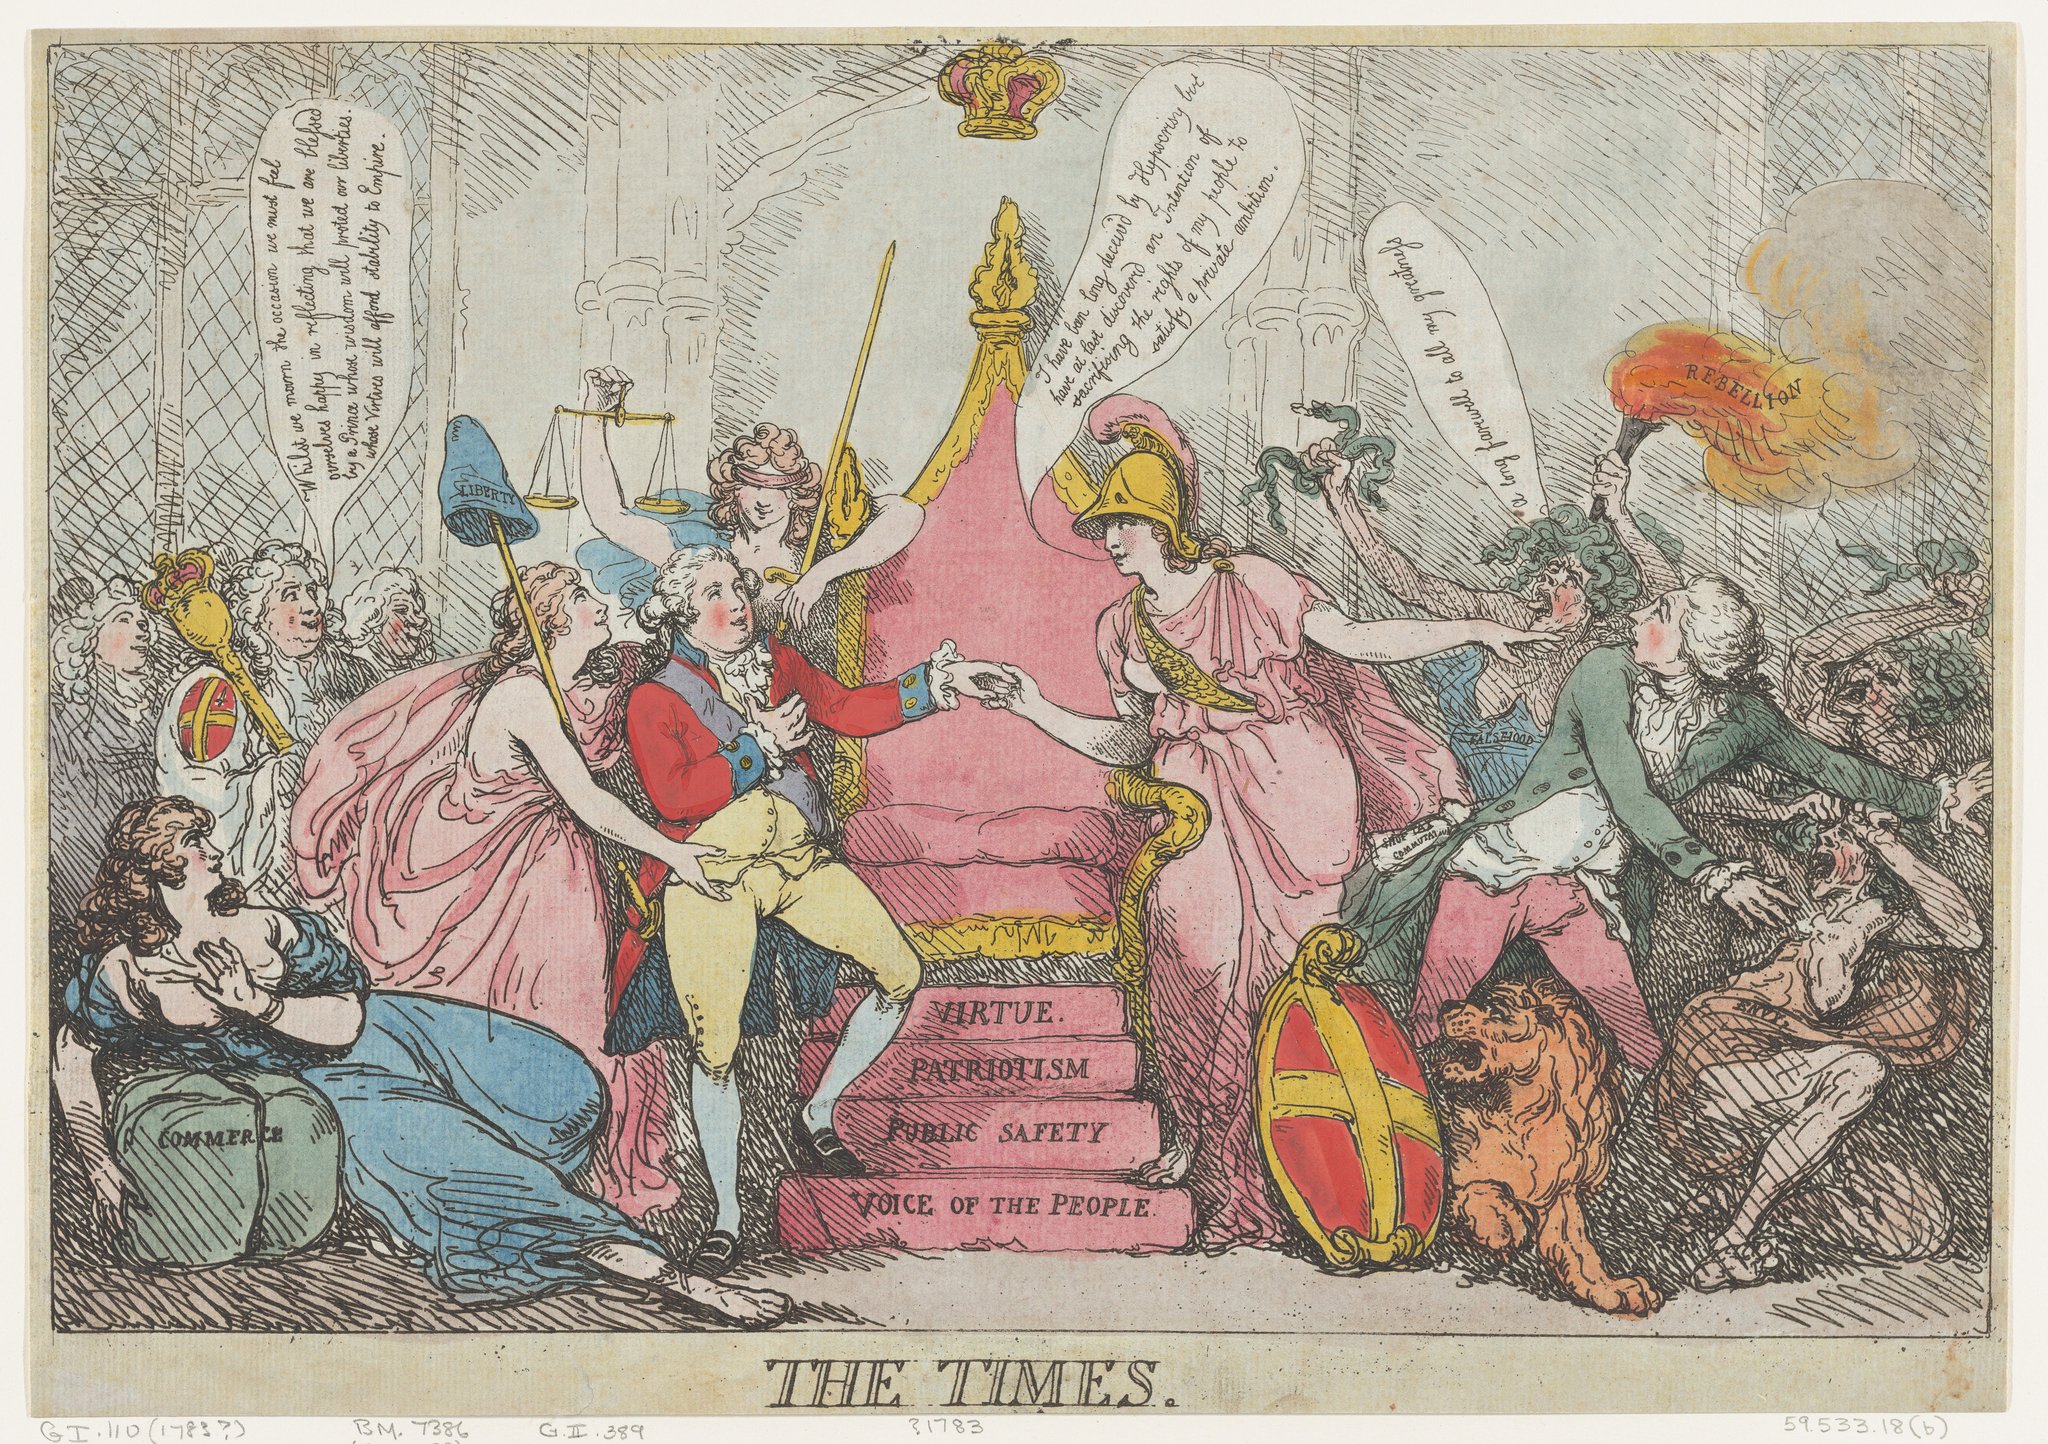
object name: print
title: The Times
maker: thomas rowlandson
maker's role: artist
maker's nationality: british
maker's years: 1757-1827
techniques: etching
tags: satire,men,women,politics